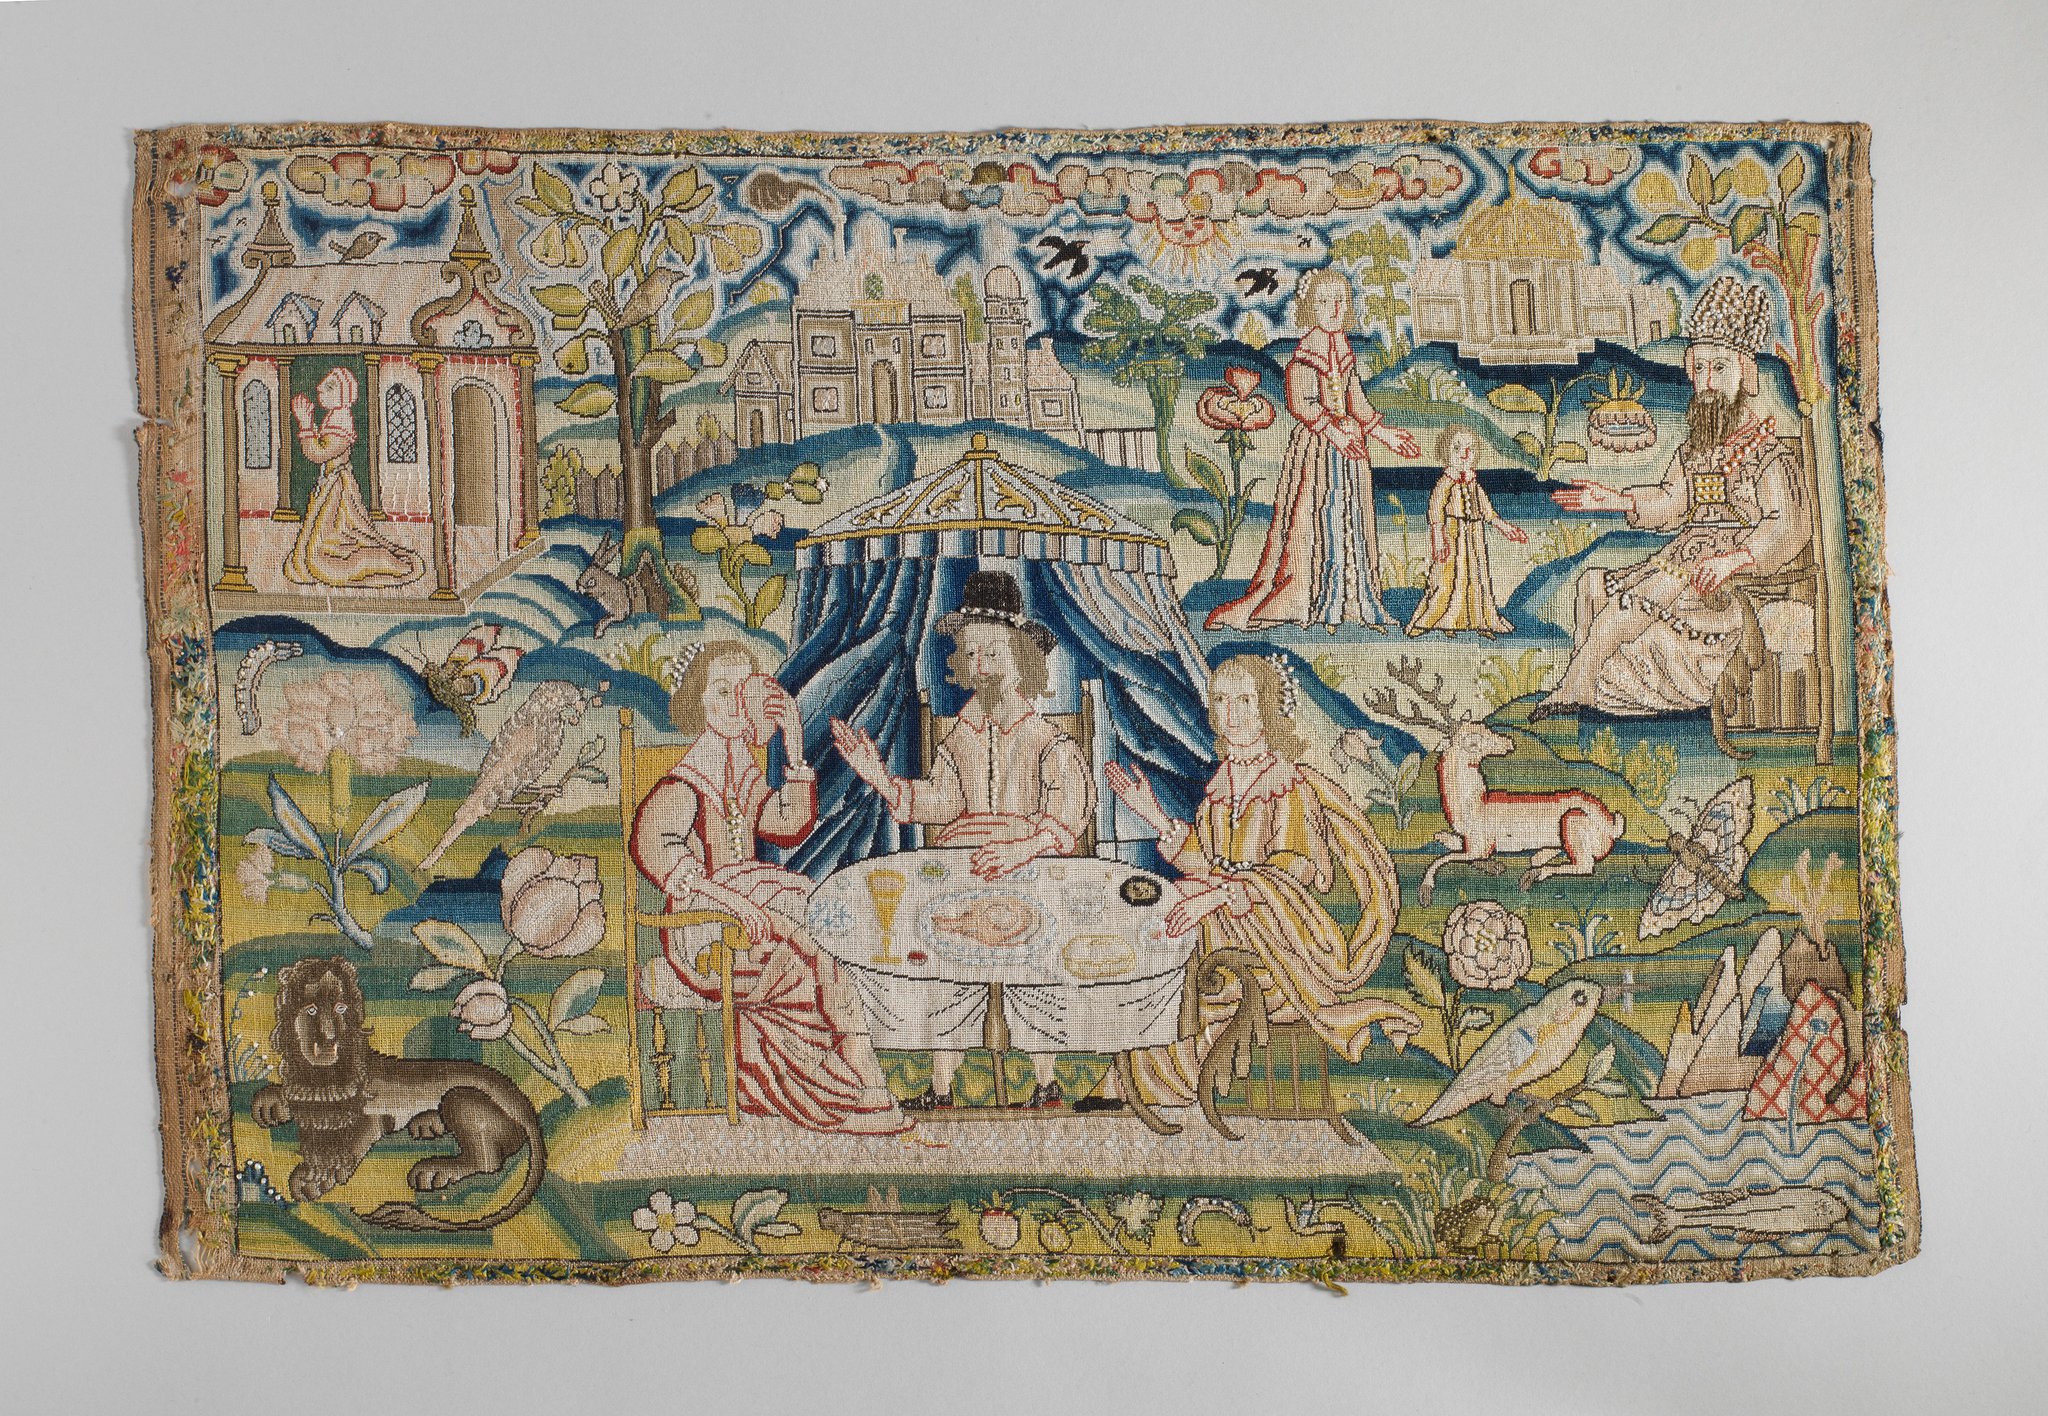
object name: embroidered picture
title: The Story of Samuel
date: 1634-1666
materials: canvas, linen, metal thread, pearl, silk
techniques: embroidery, stitching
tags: birds,men,women,deer,butterflies,lions,dining